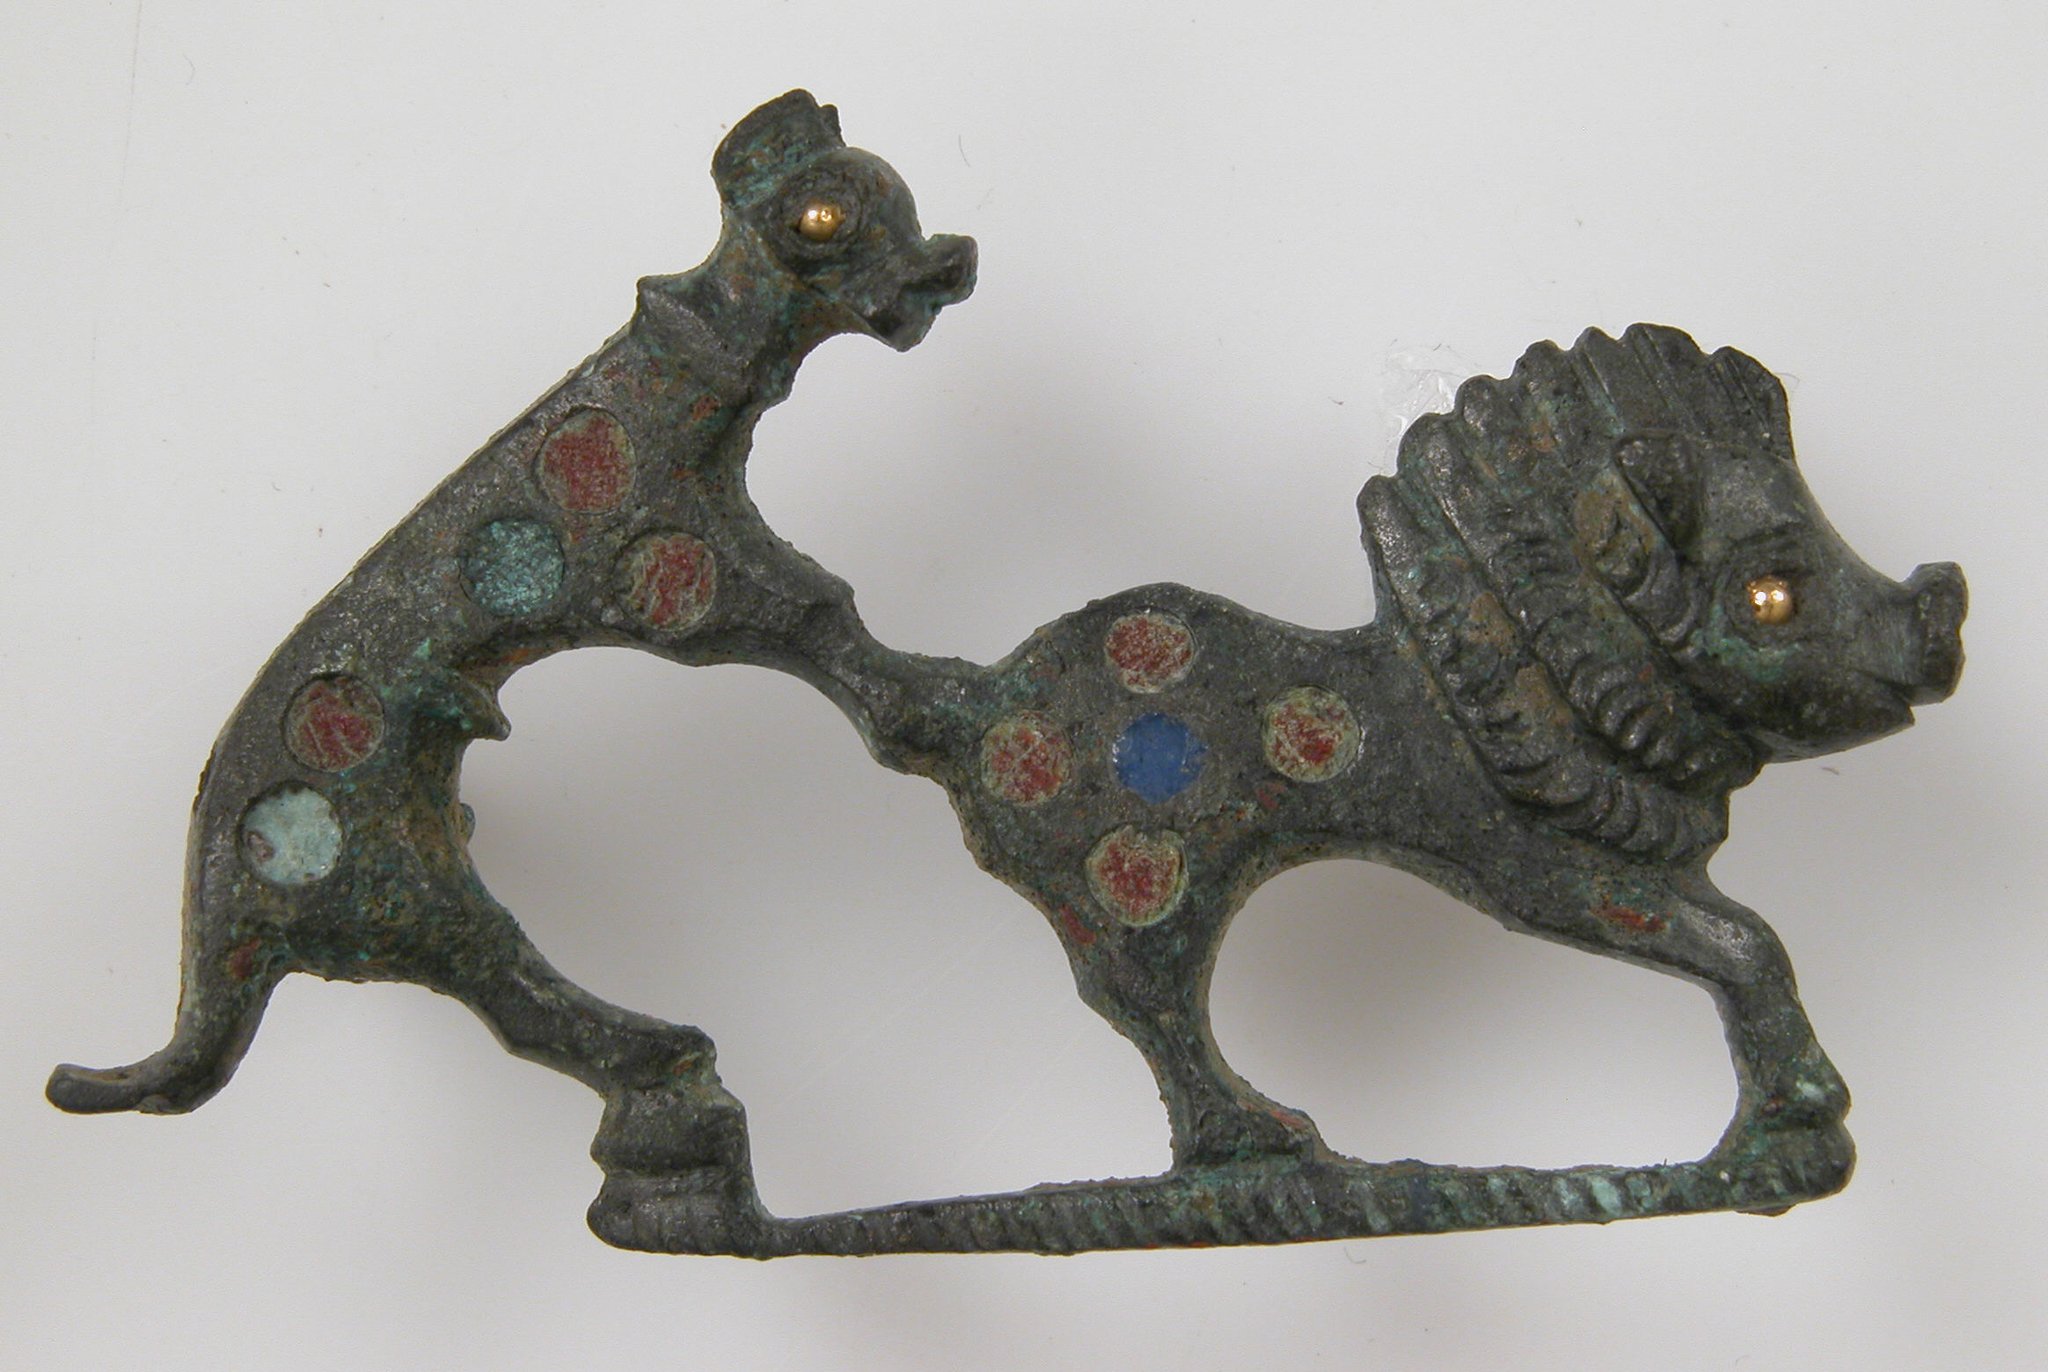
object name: brooch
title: Brooch in the Form of a Dog Attacking a Boar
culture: roman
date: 101-200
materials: bronze, enamel, gold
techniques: enamel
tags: boars,dogs